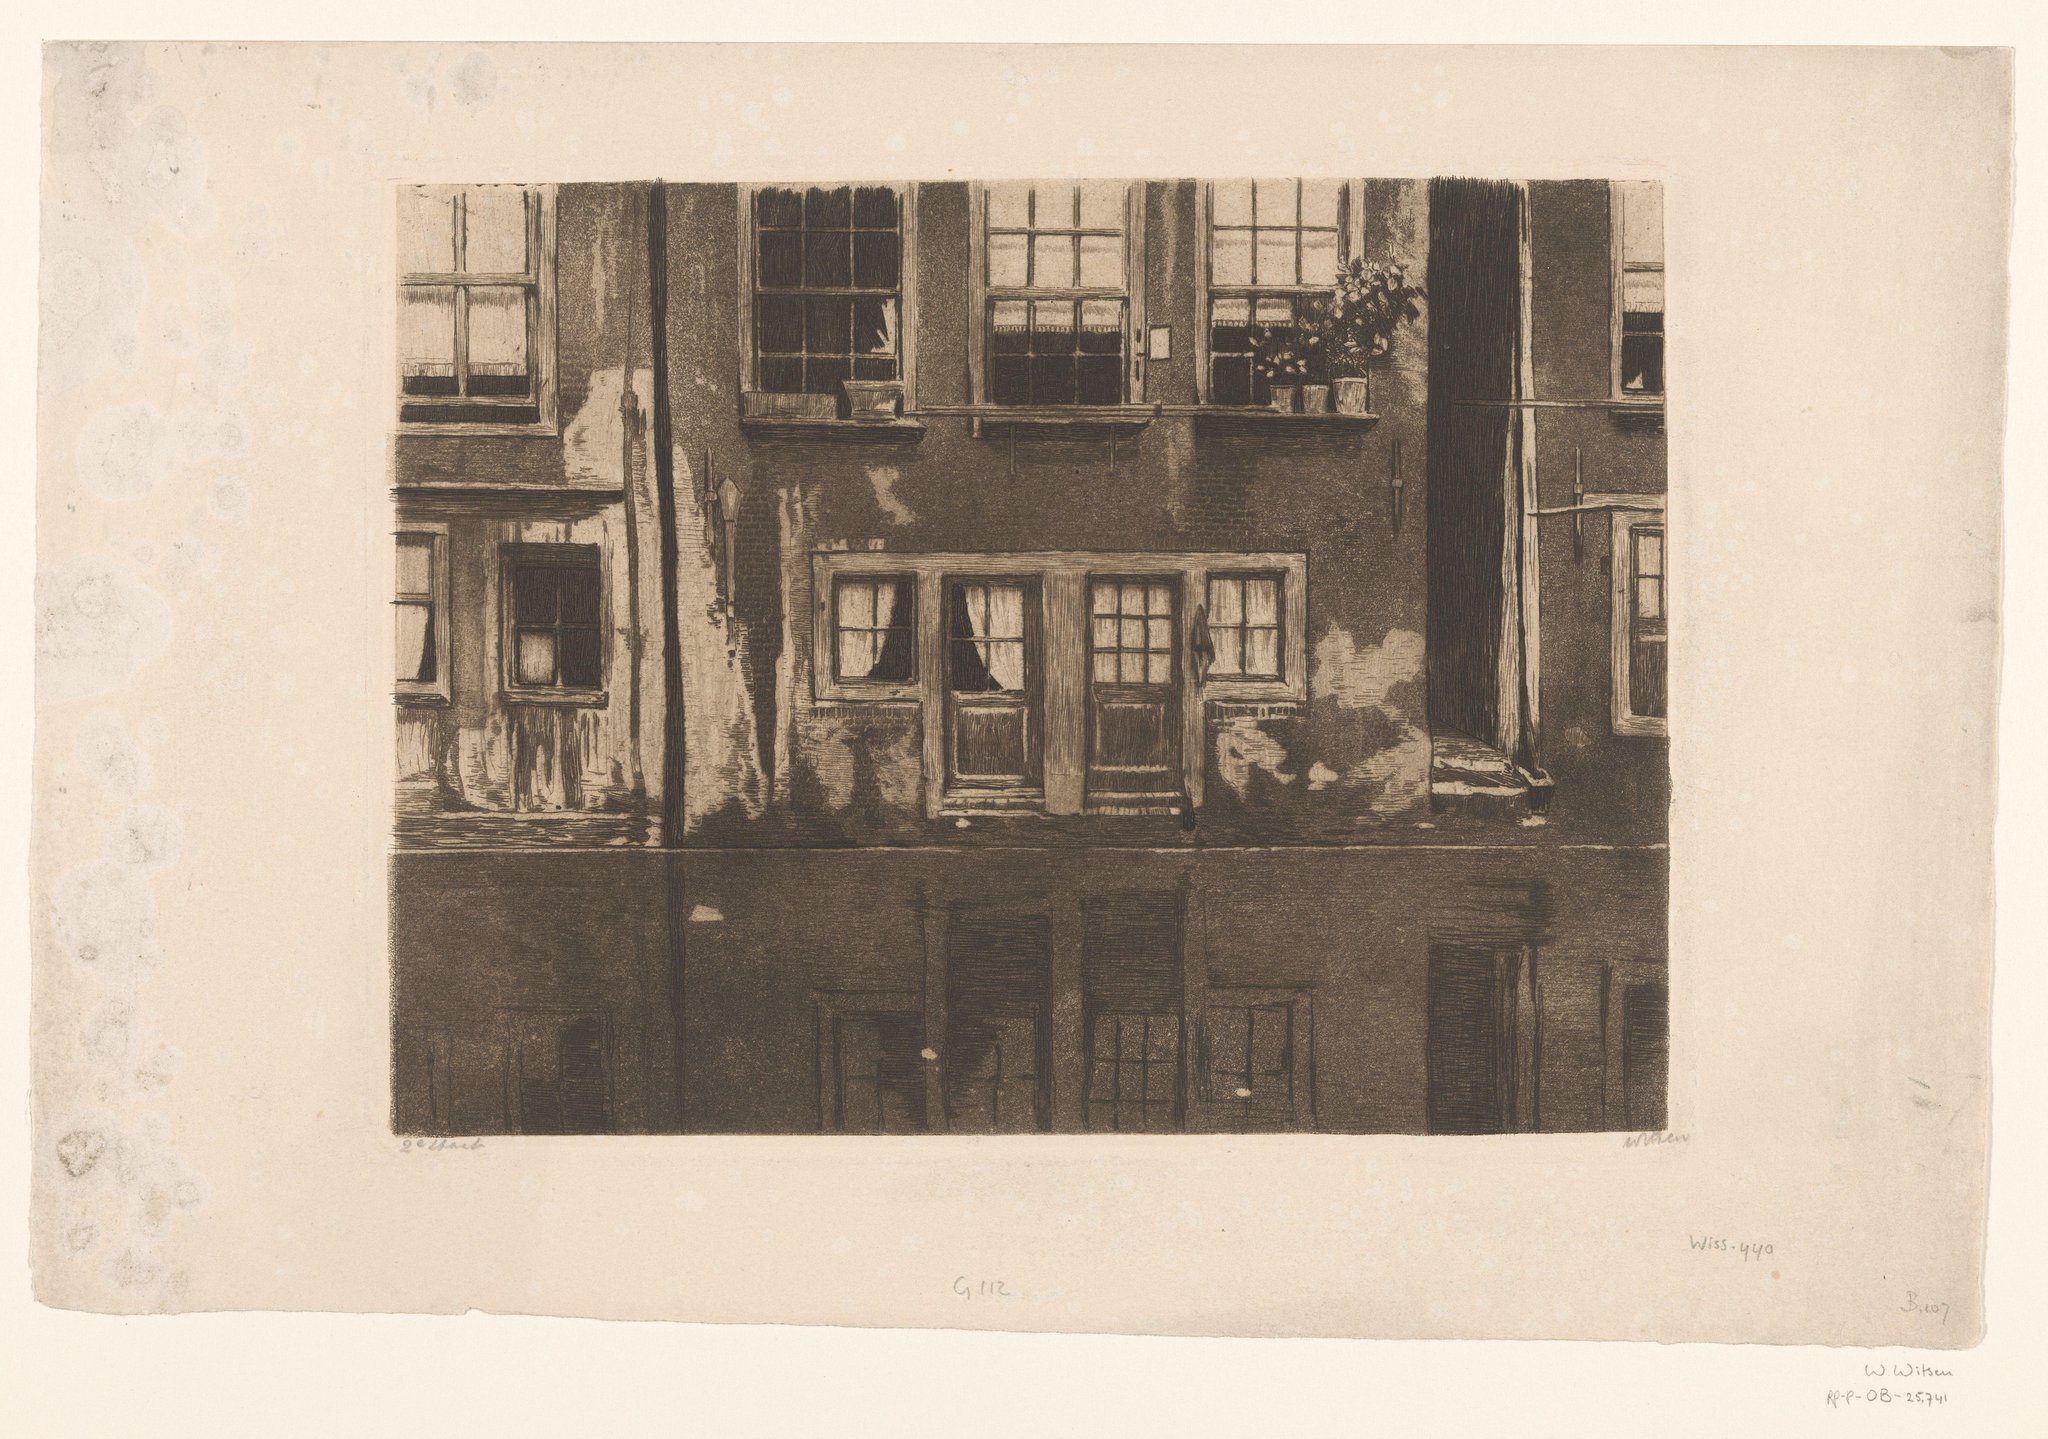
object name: print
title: Huizen aan de Oudezijds Achterburgwal in Amsterdam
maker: willem witsen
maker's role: draughtsman, painter, print maker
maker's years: 1860-1923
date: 1905-1906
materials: paper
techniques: aquatint, etching, intaglio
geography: amsterdam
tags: urban housing, window, canals, waters (in city)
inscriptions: collector's mark: Lugt 2228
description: Gezicht op de achterkant van de huizen aan de Zeedijk, tussen de Spooksteeg en de Korte Niezel. Gezien vanaf de Oudezijds Achterburgwal in Amsterdam.